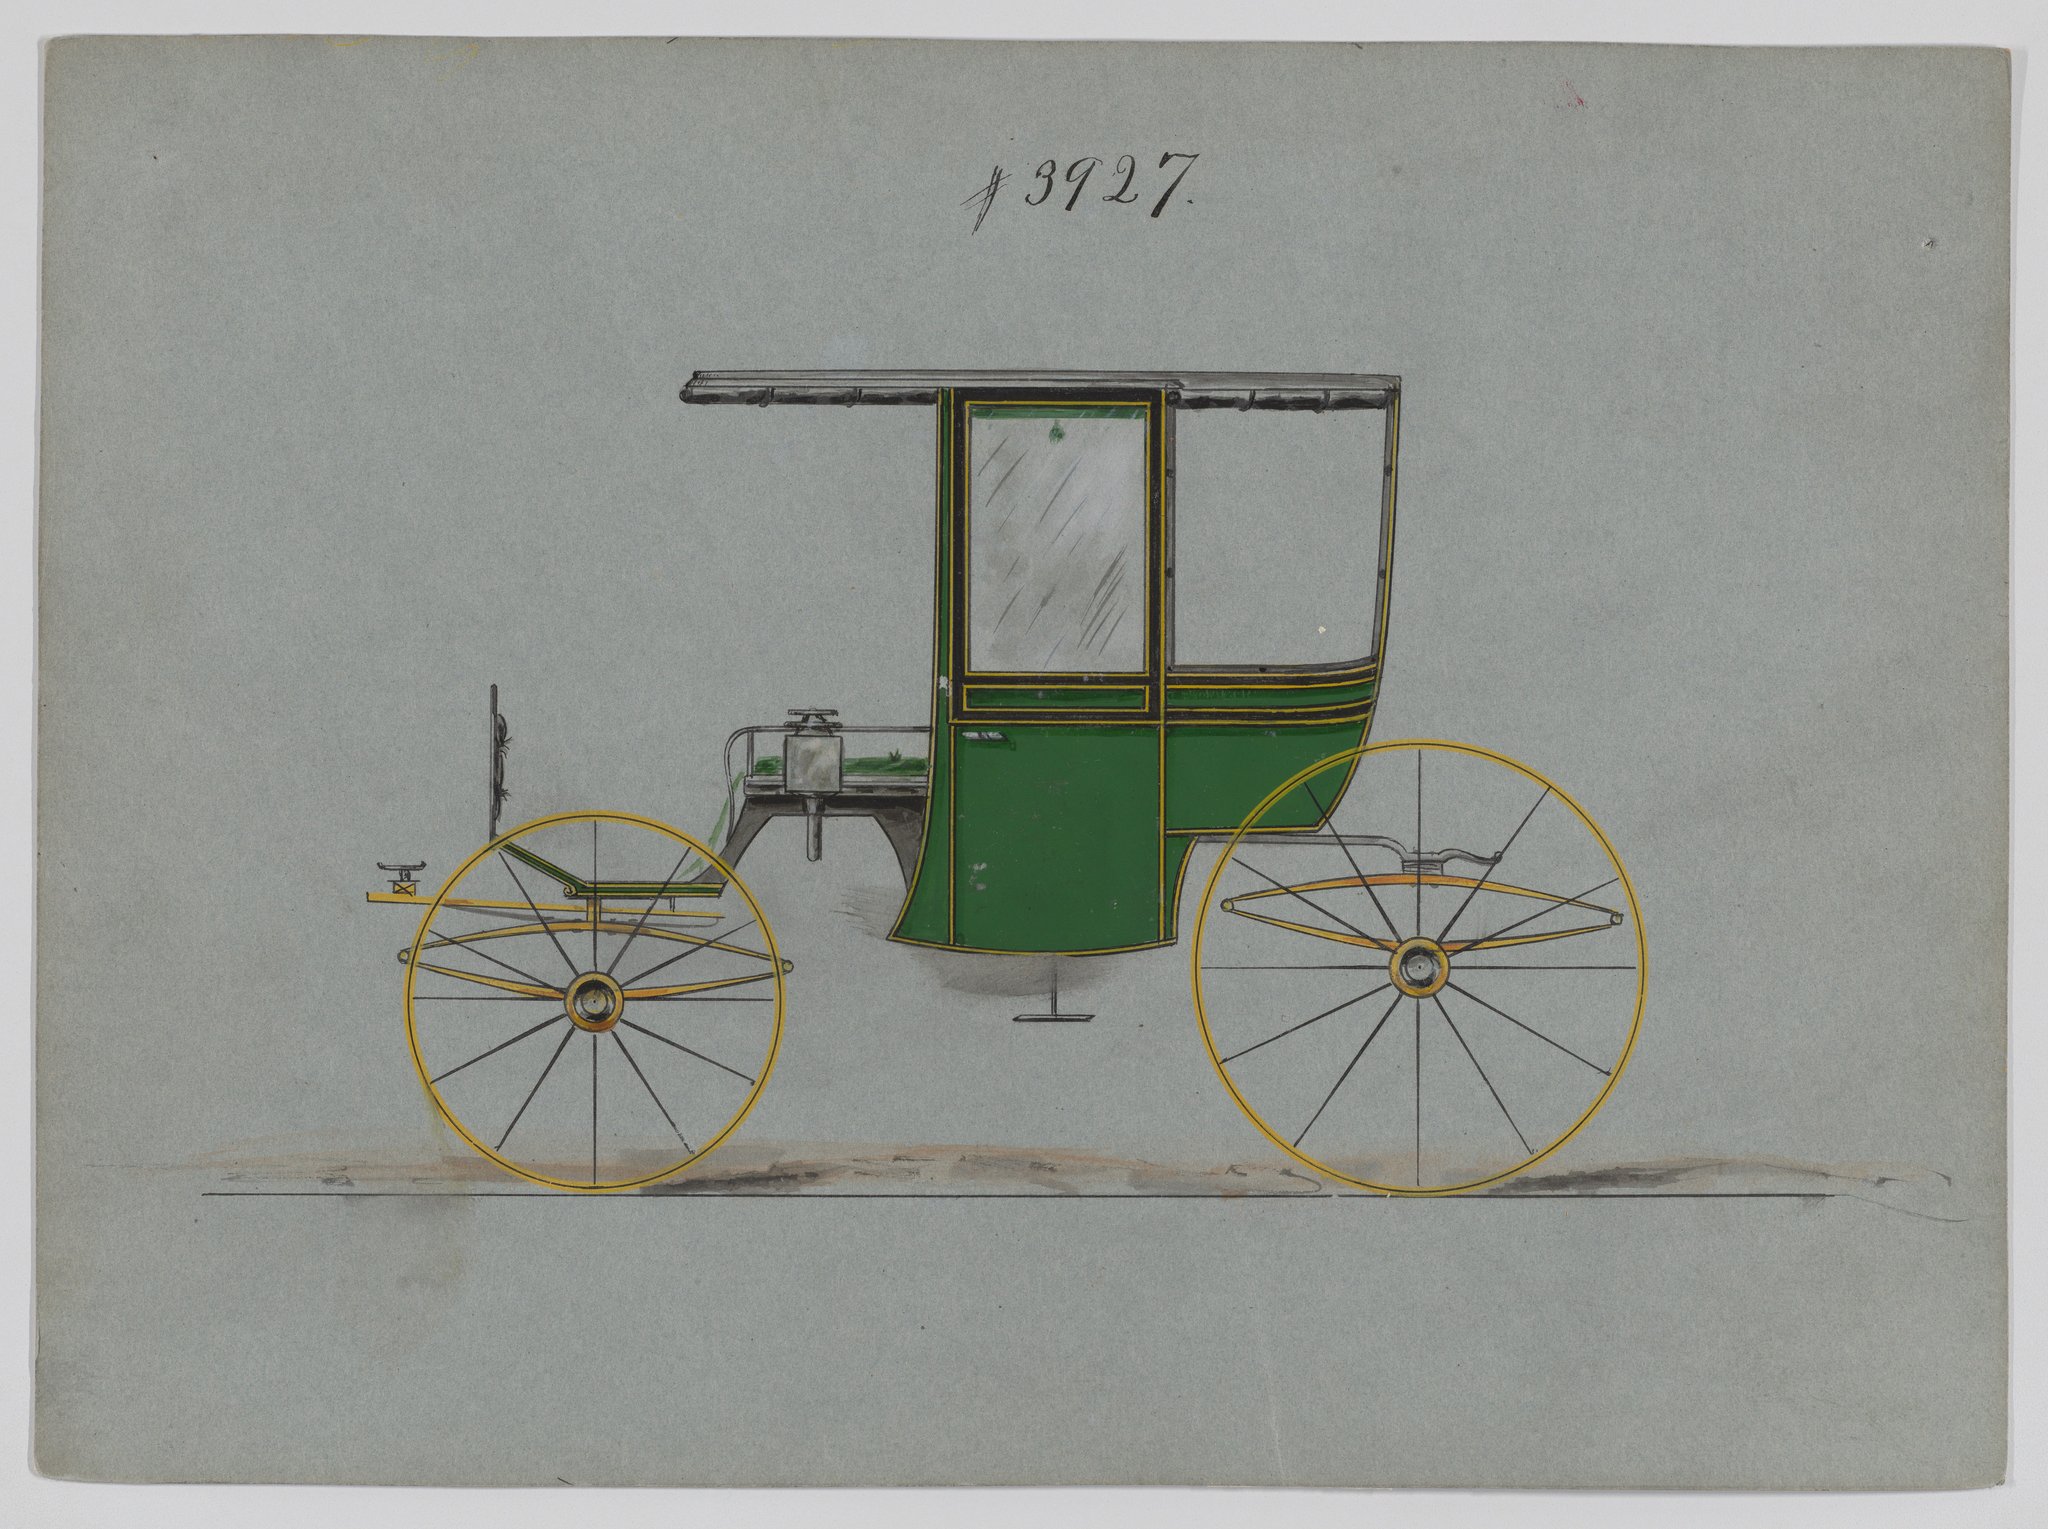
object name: drawing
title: Design for 4 seat Rockaway, no. 3927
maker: brewster & co.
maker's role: manufacturer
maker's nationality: american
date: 1884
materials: gouache, gum arabic, ink, watercolor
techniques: pen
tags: carriages